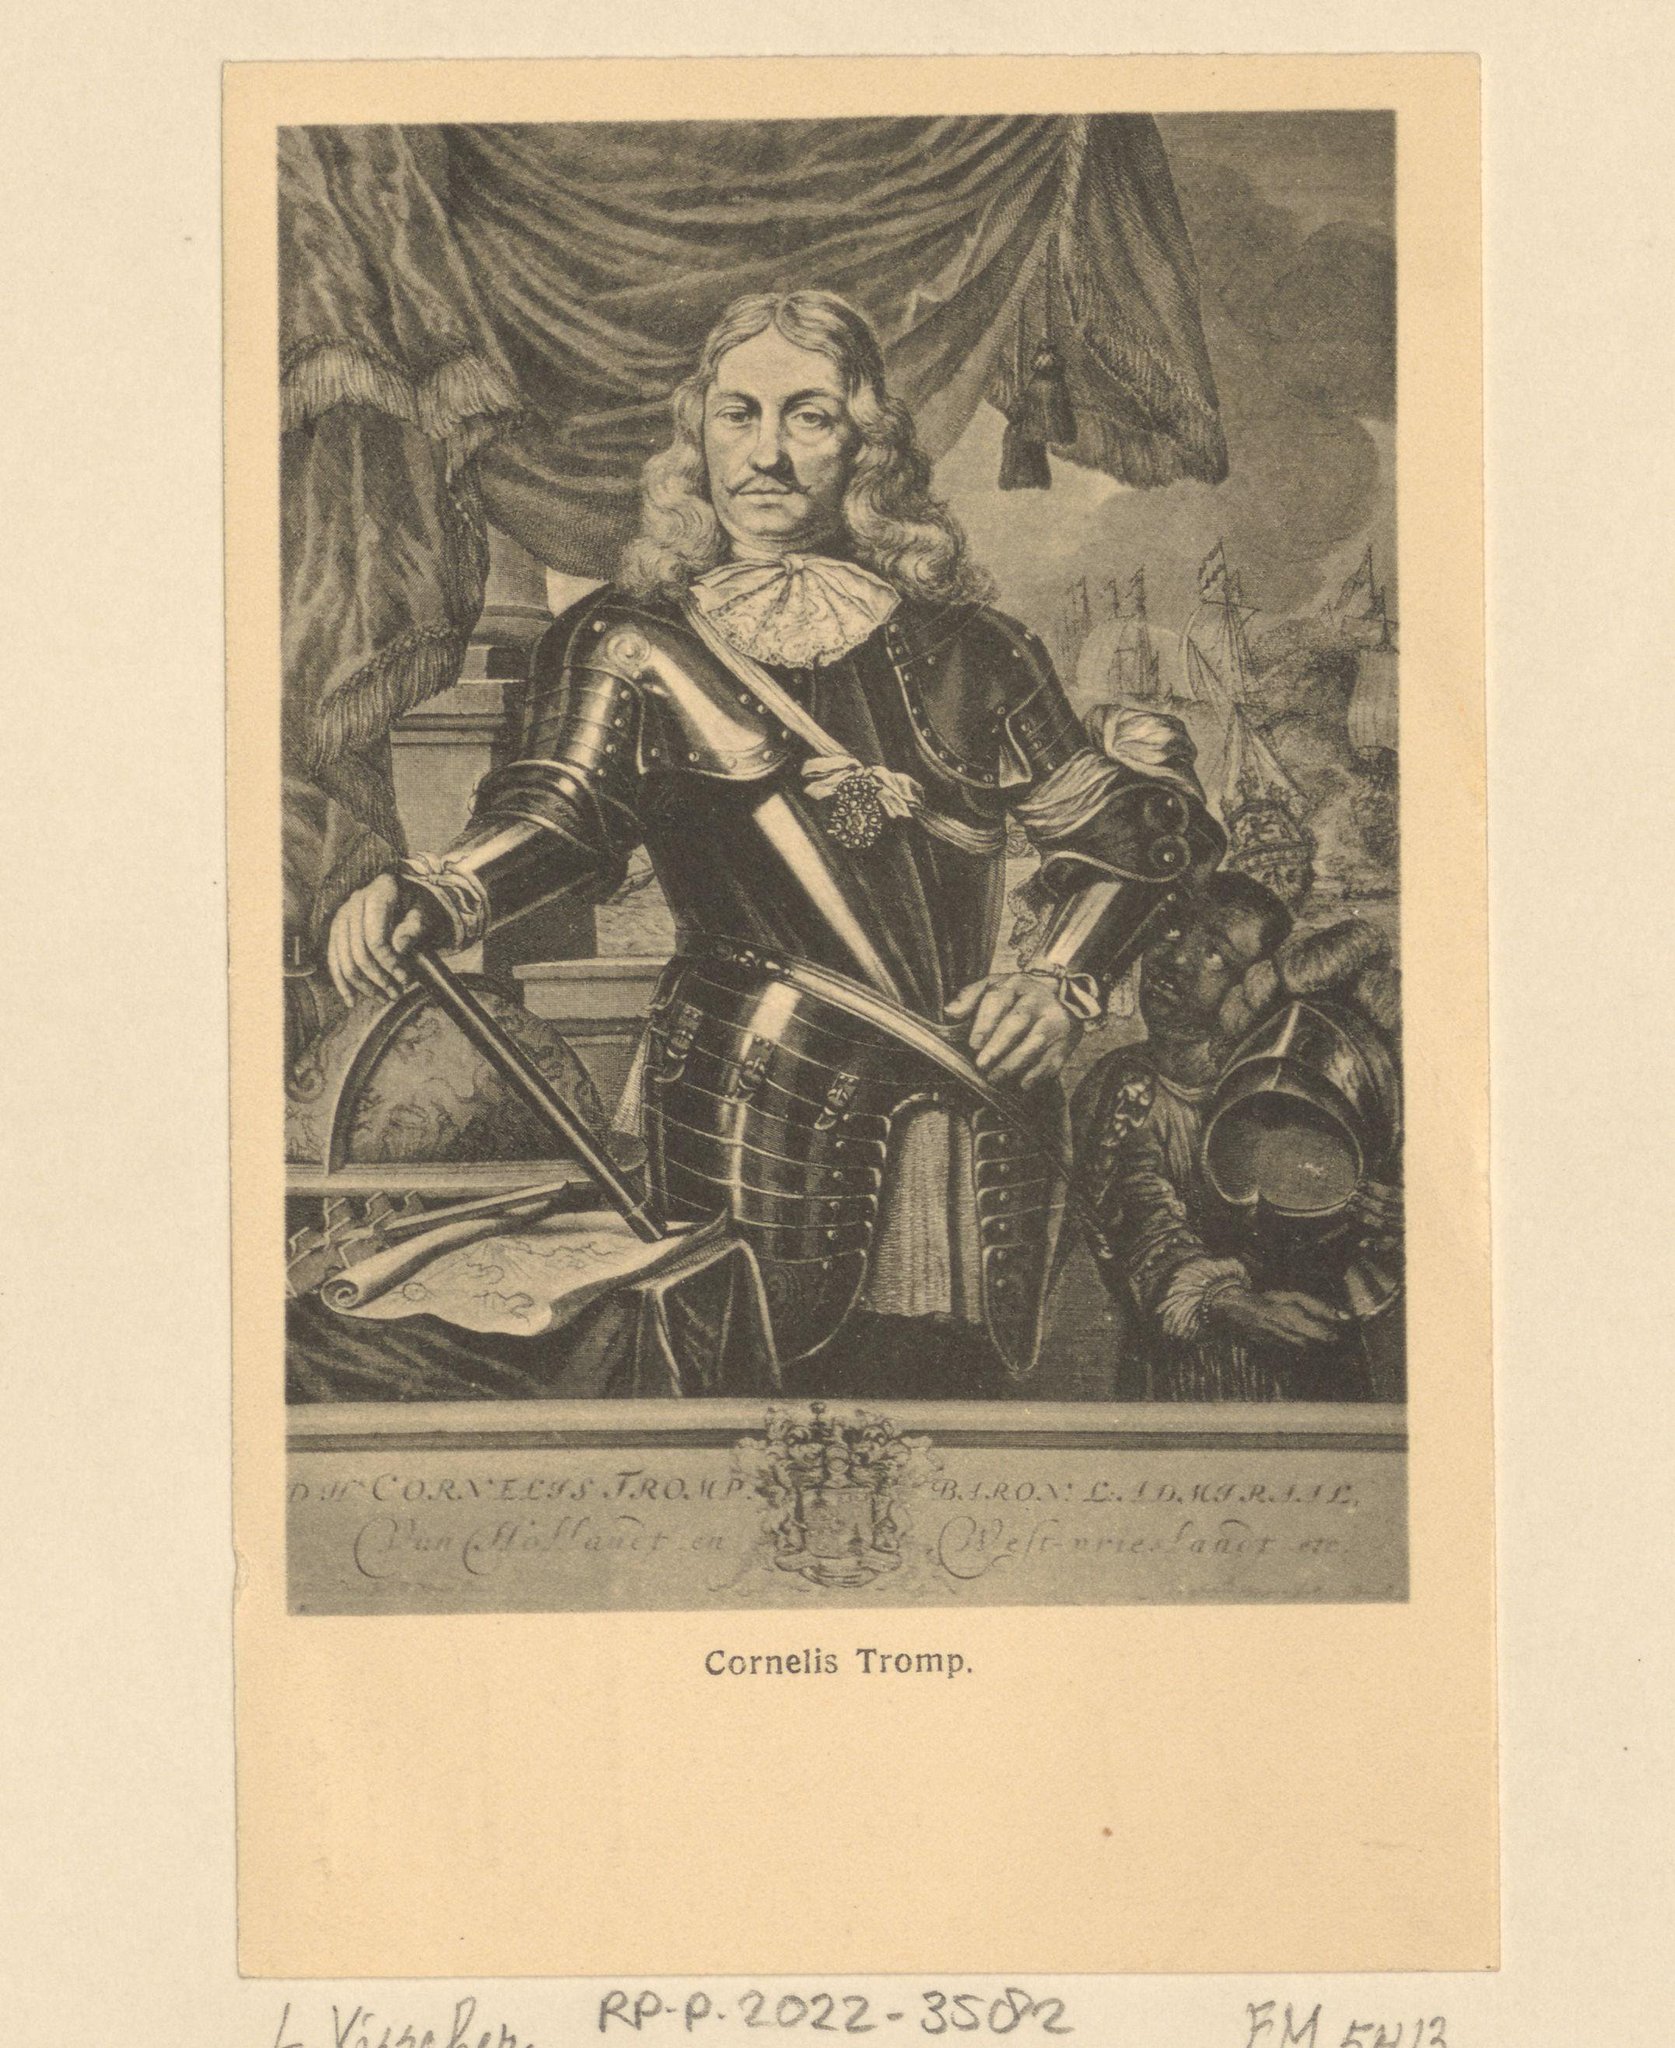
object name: ansichtkaart, prentbriefkaart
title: Portret van Cornelis Tromp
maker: Anonymous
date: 1905-1930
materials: paper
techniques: photograph, letterpress printing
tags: amsterdam, cornelis tromp, armour, historical persons, commander-in-chief, admiral